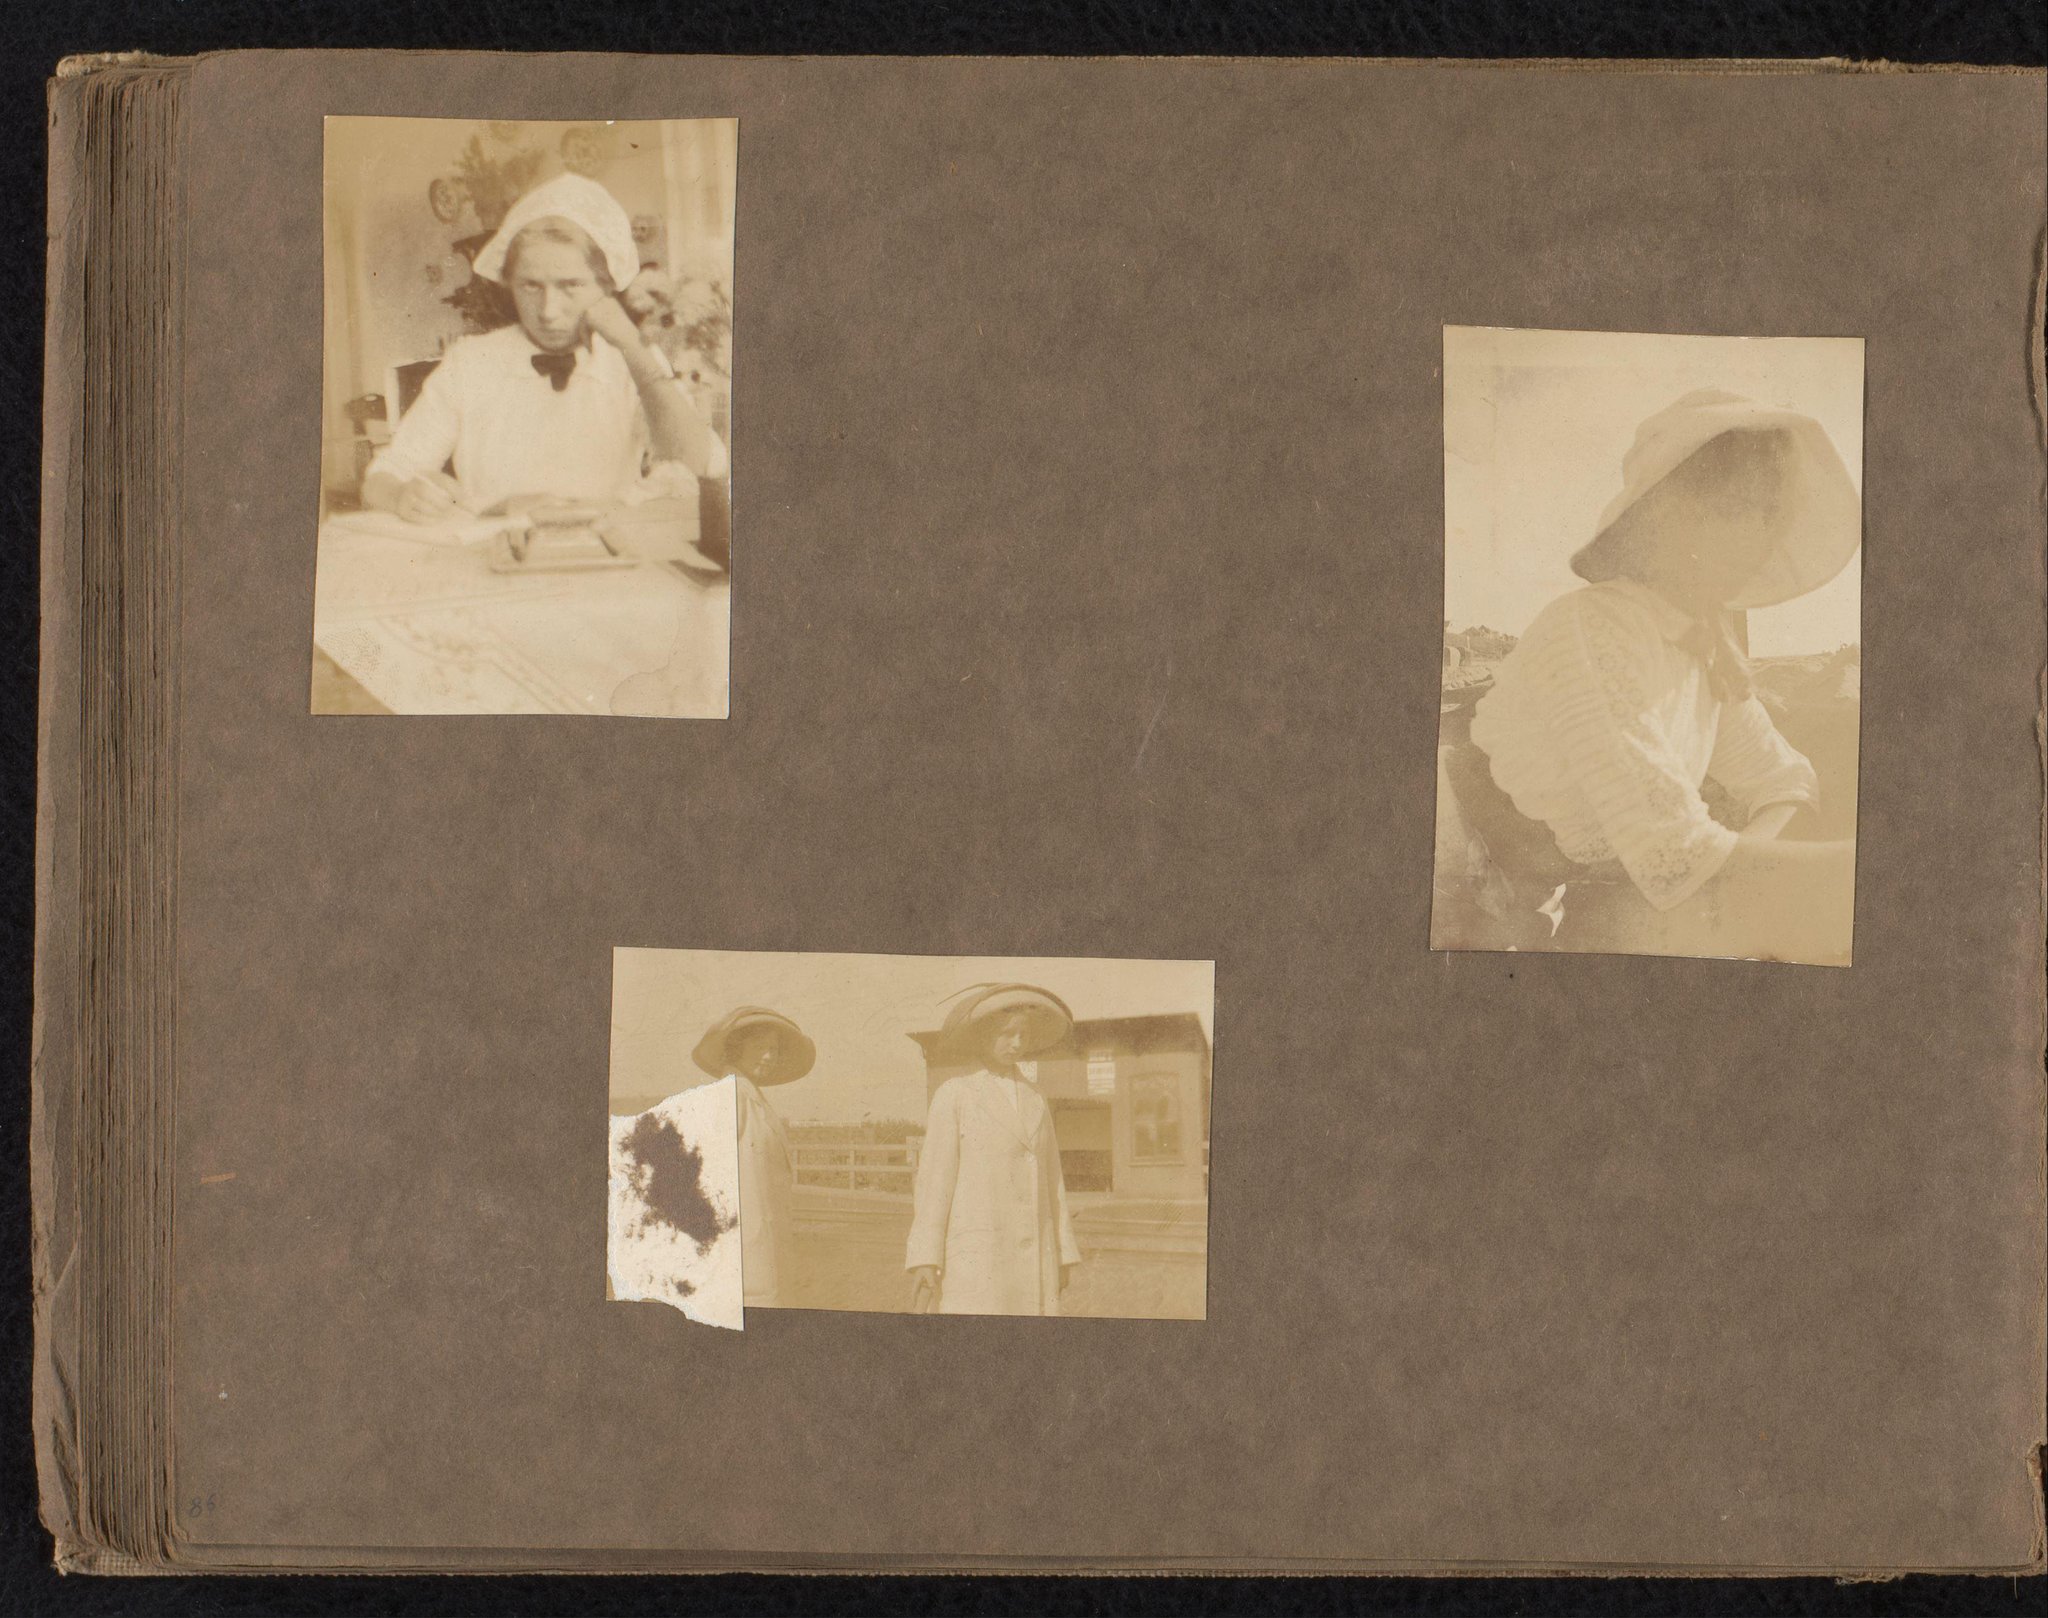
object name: photograph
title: Drie foto's van een vakantie in Noordwijk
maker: carolina frederika onnen (lien/loen)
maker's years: 1896-1983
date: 1908-1911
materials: paper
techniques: gelatin silver print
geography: noordwijk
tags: historical persons not known by name - bb - woman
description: Deze foto's maken deel uit van een album.